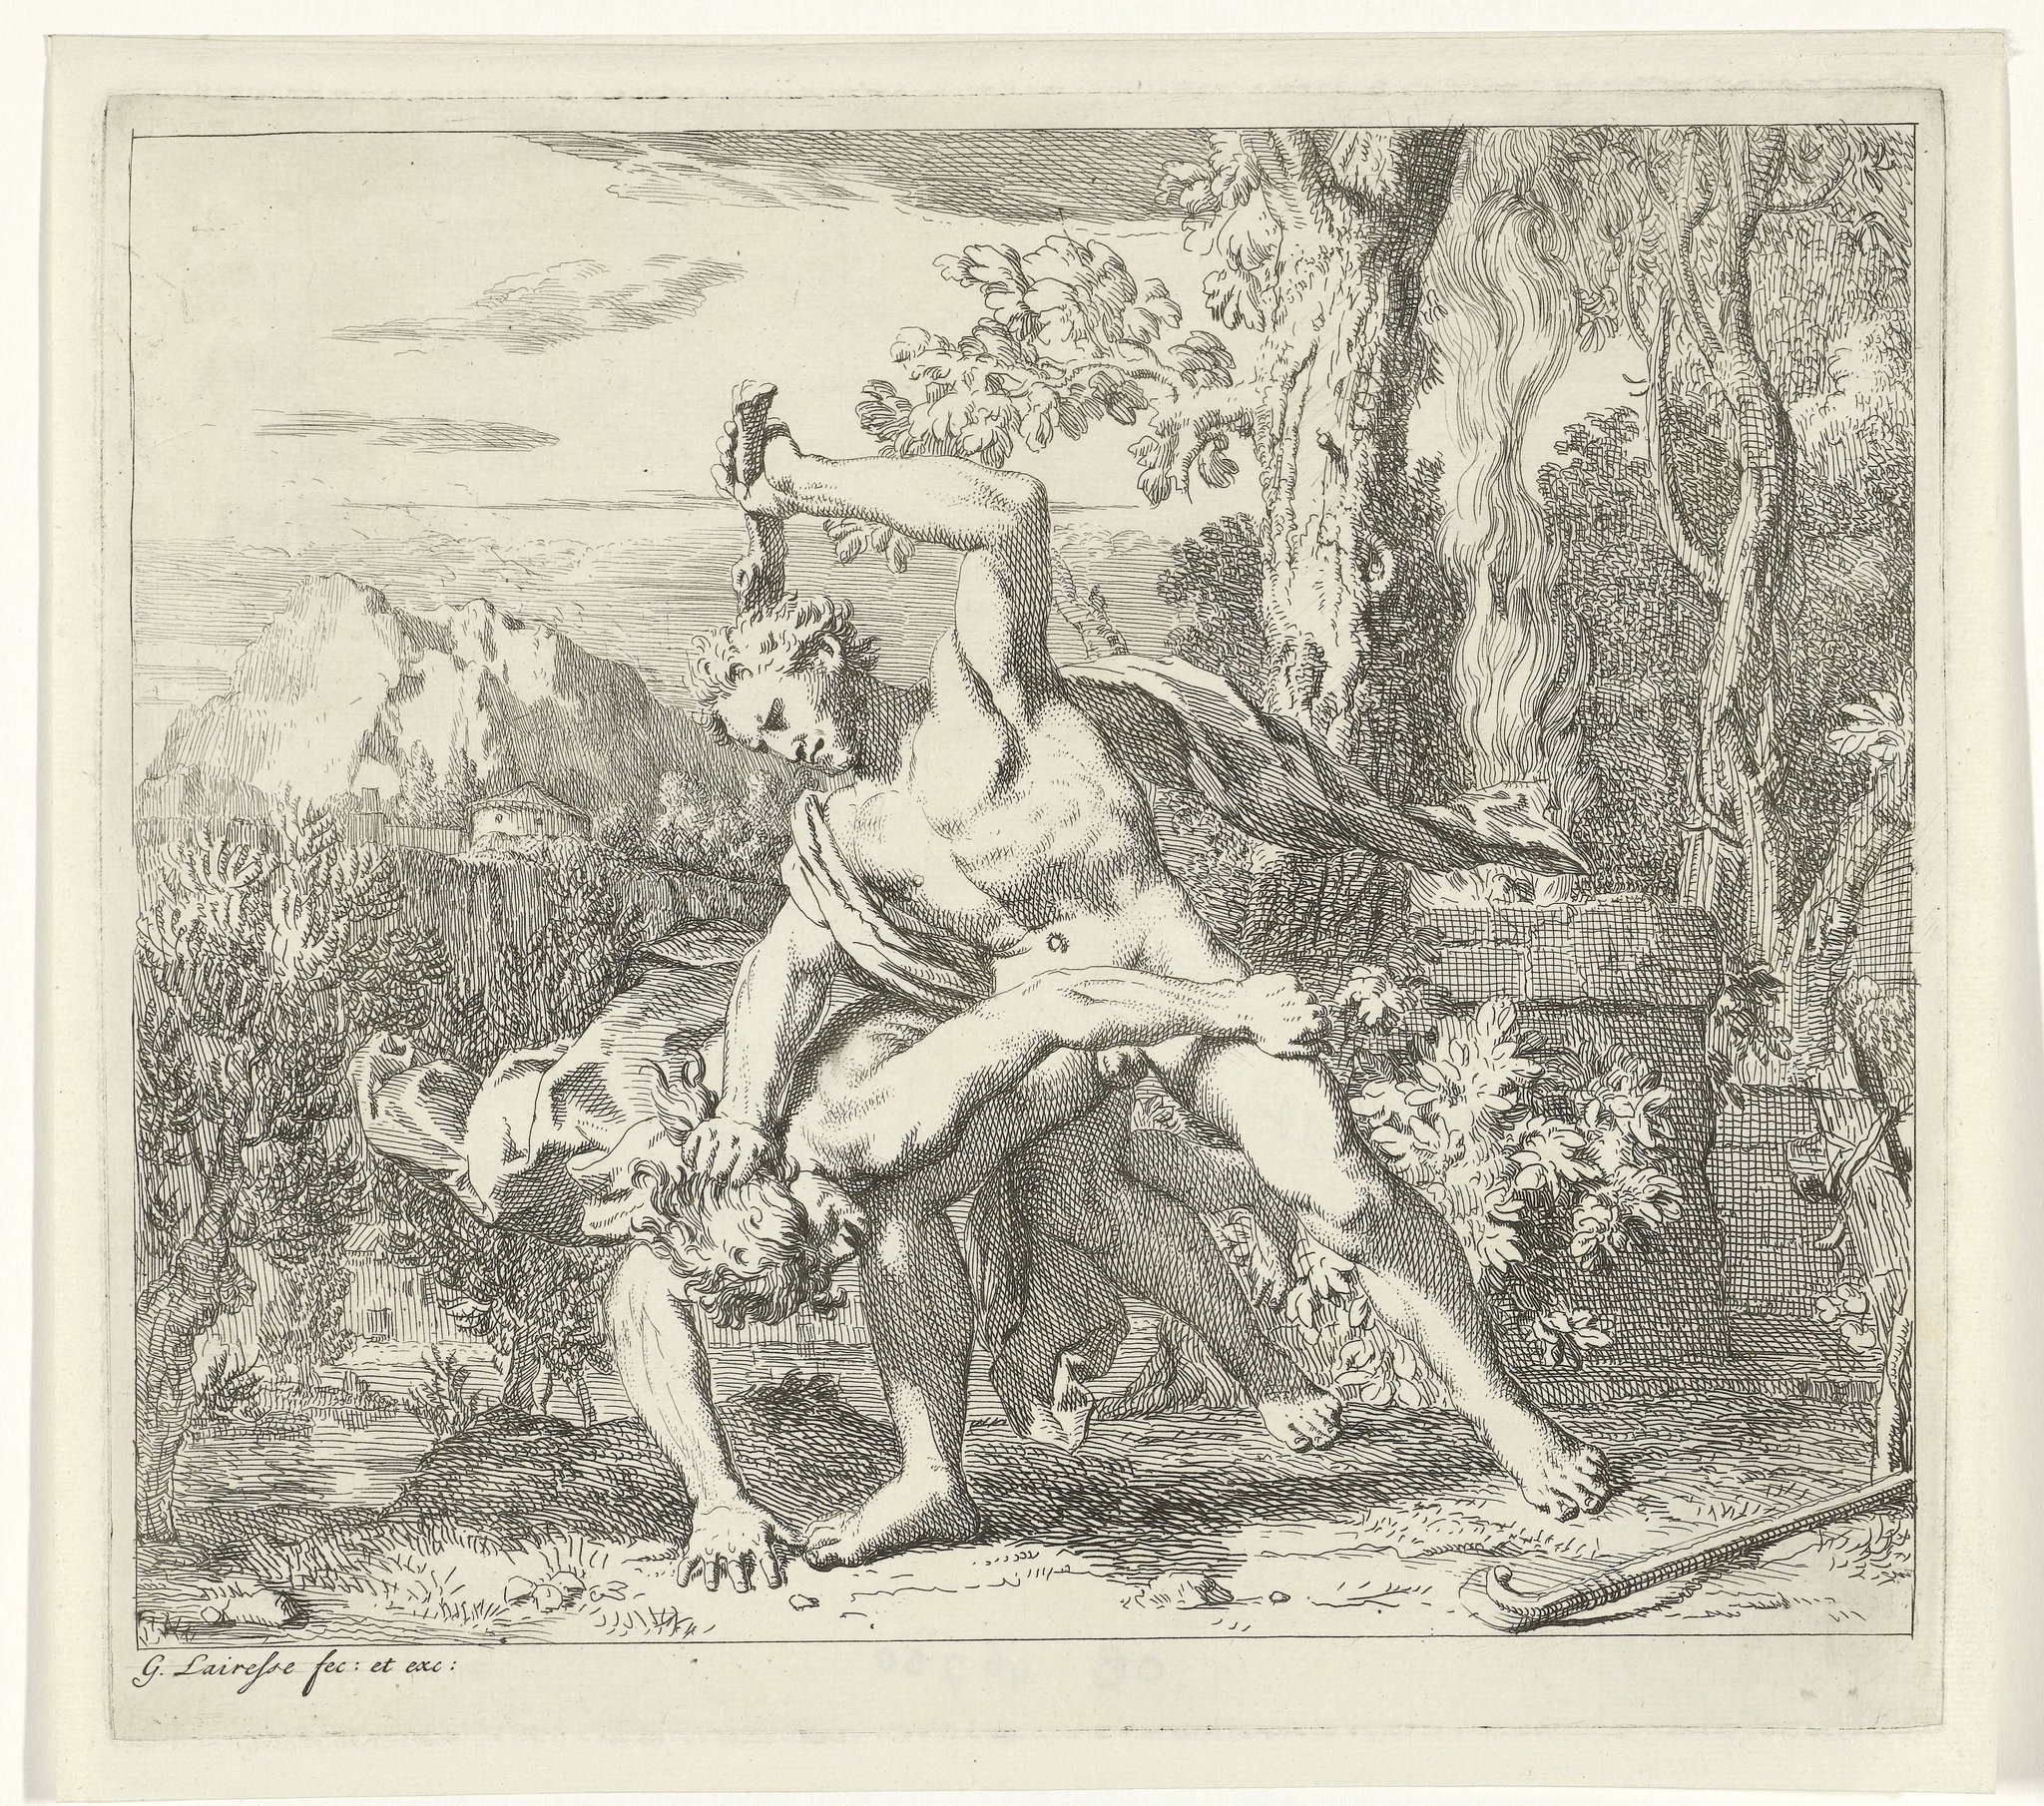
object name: print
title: Kaïn doodt Abel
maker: gerard de lairesse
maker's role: draughtsman, painter, print maker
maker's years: 1641-1711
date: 1665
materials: paper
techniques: etching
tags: the killing of abel: cain slays him with a stone, a club or a jaw-bone, alternatively with a spade or another tool as weapon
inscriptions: collector's mark: Lugt 240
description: Kaïn staat met opgeheven bot op het punt om Abel te slaan. Hij heeft Abel bij zijn haren vastgegrepen en duwt hem tegen de grond. De prent maakt deel uit van een zevendelige serie met scènes uit het Bijbelboek Genesis.